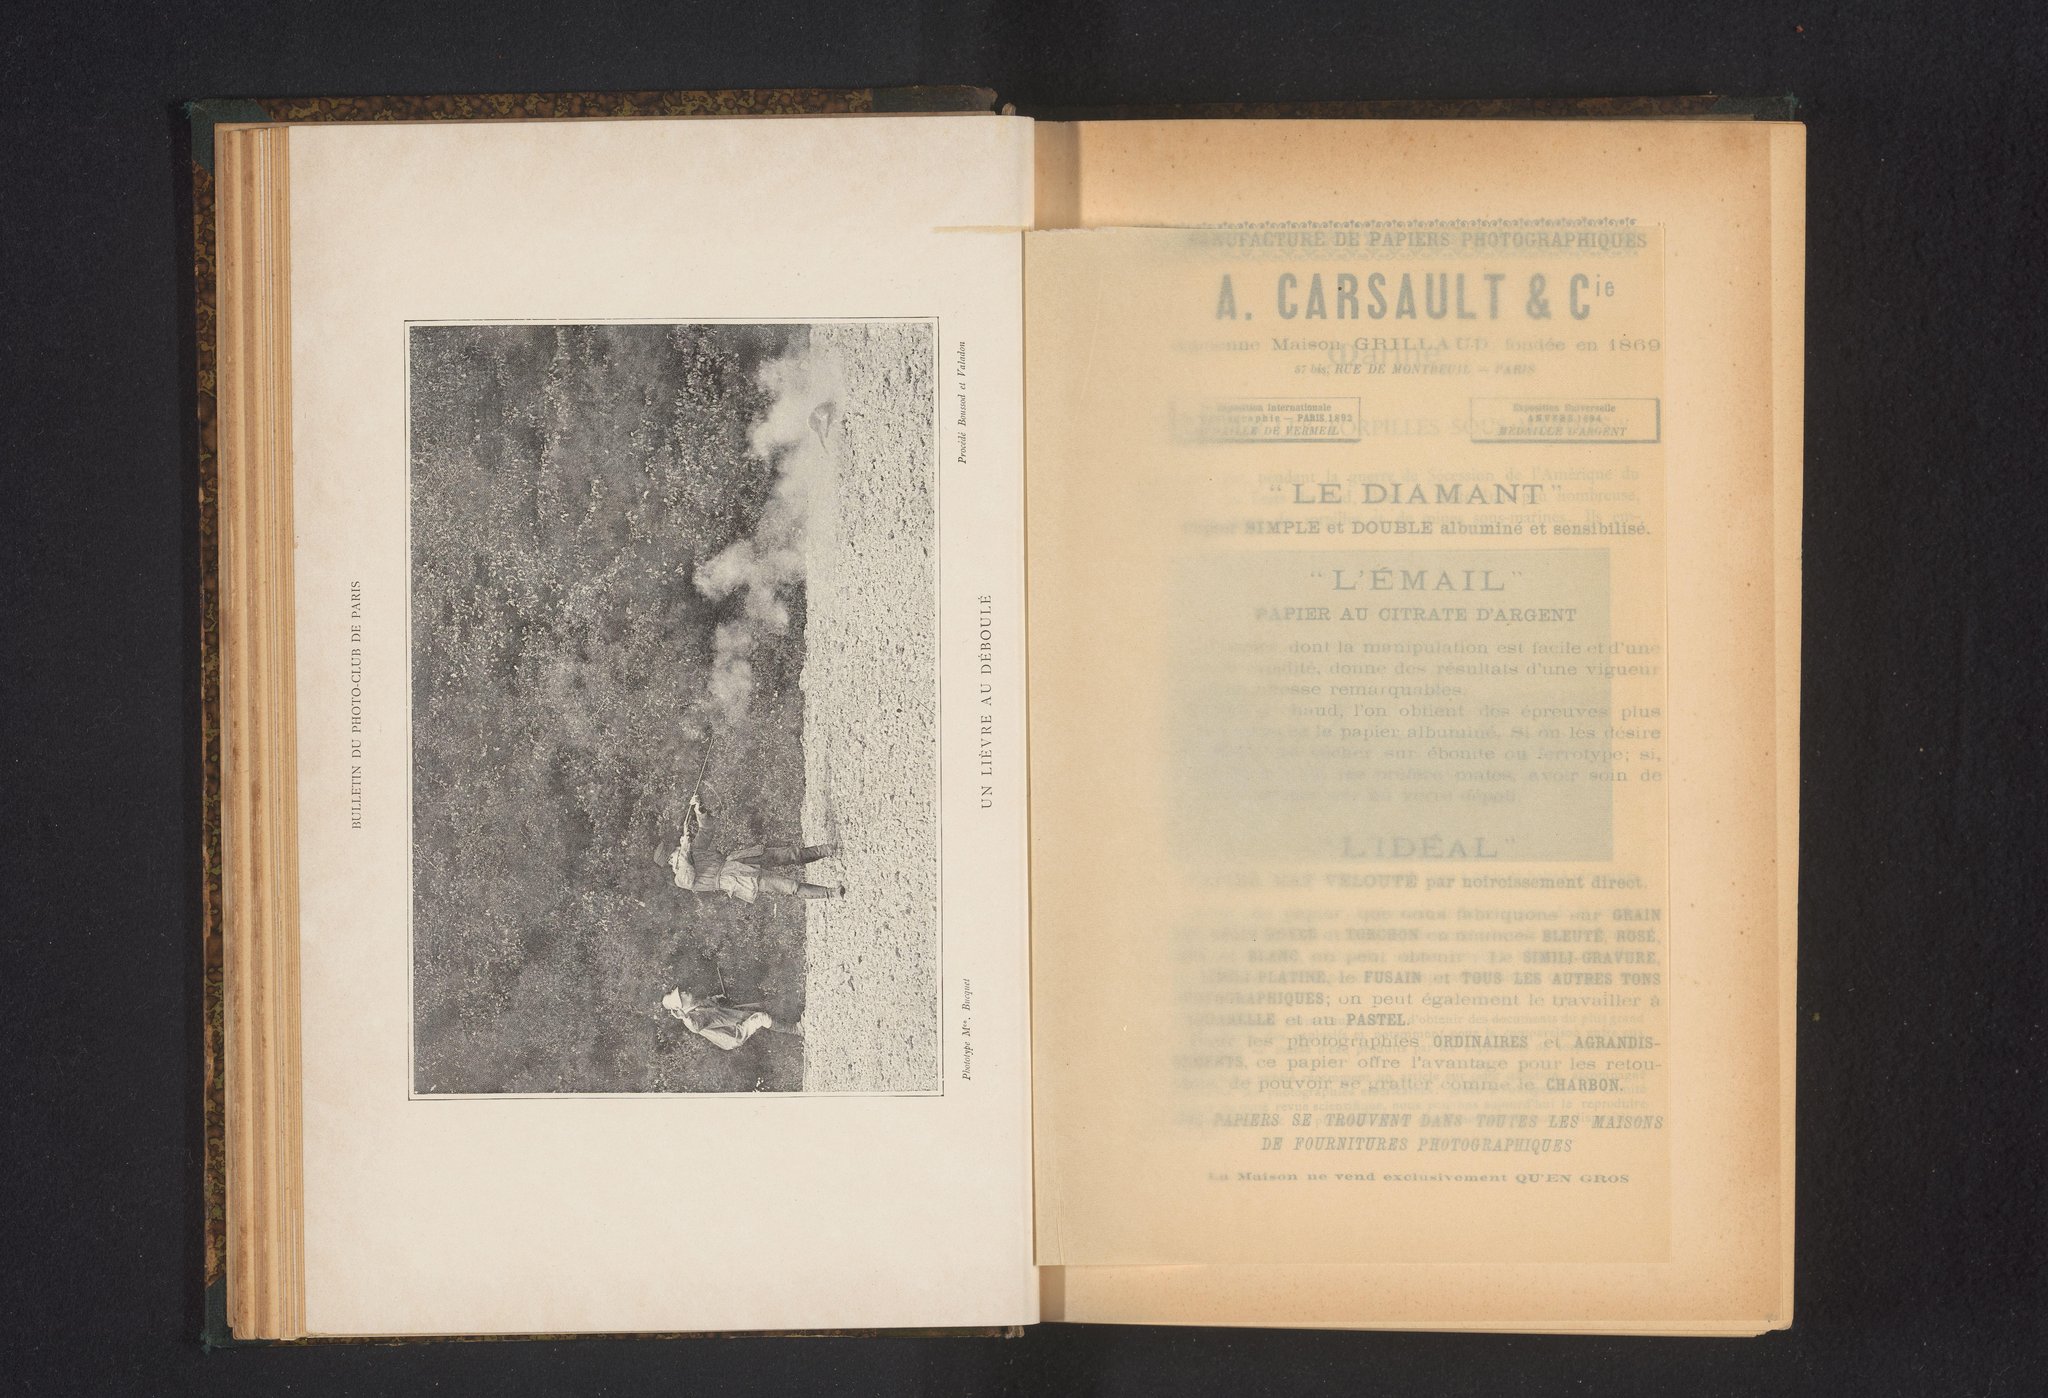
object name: page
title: Un Lièvre au Déboulé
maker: maurice bucquet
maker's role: fotograaf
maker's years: 1860-1921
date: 1890-1895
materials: paper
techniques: autotype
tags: hunters hunting (n.b.: in 1988-1990 this notation denoted the concept of 43c11421 'hunters resting during the hunt'), rodents: rabbit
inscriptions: inscription: ‘Bulletin du Photo-Club de Paris’, inscription: ‘Procédé Boussod et Valadon’